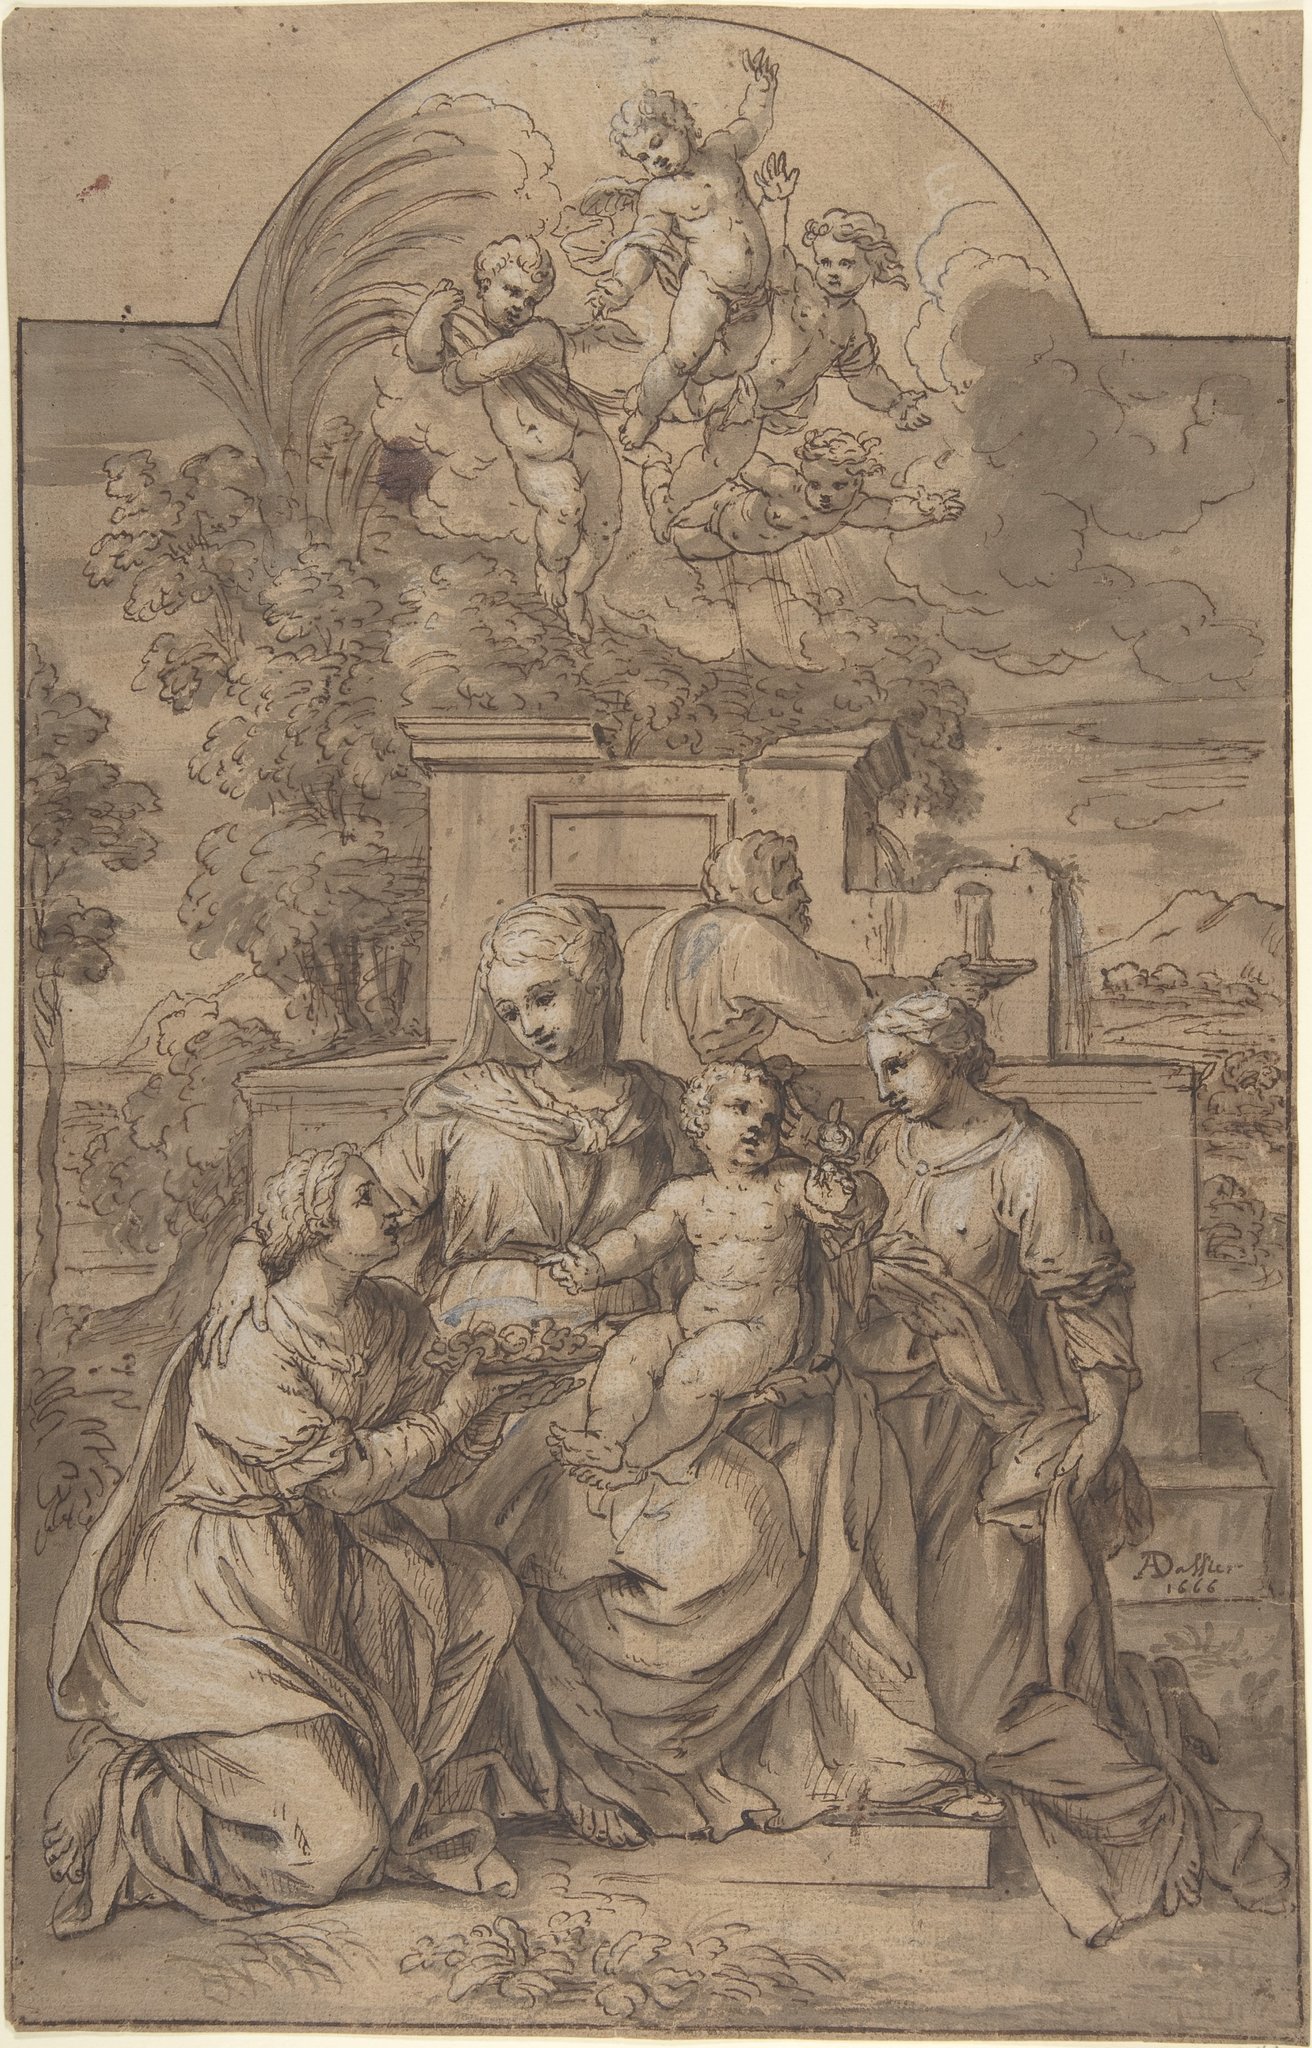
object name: drawing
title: The Rest on the Flight into Egypt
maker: adrien dassier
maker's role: artist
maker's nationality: french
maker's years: 1630-1672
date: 1666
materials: chalk, ink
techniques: brush, heightening, pen, drawing, wash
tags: women,madonna and child